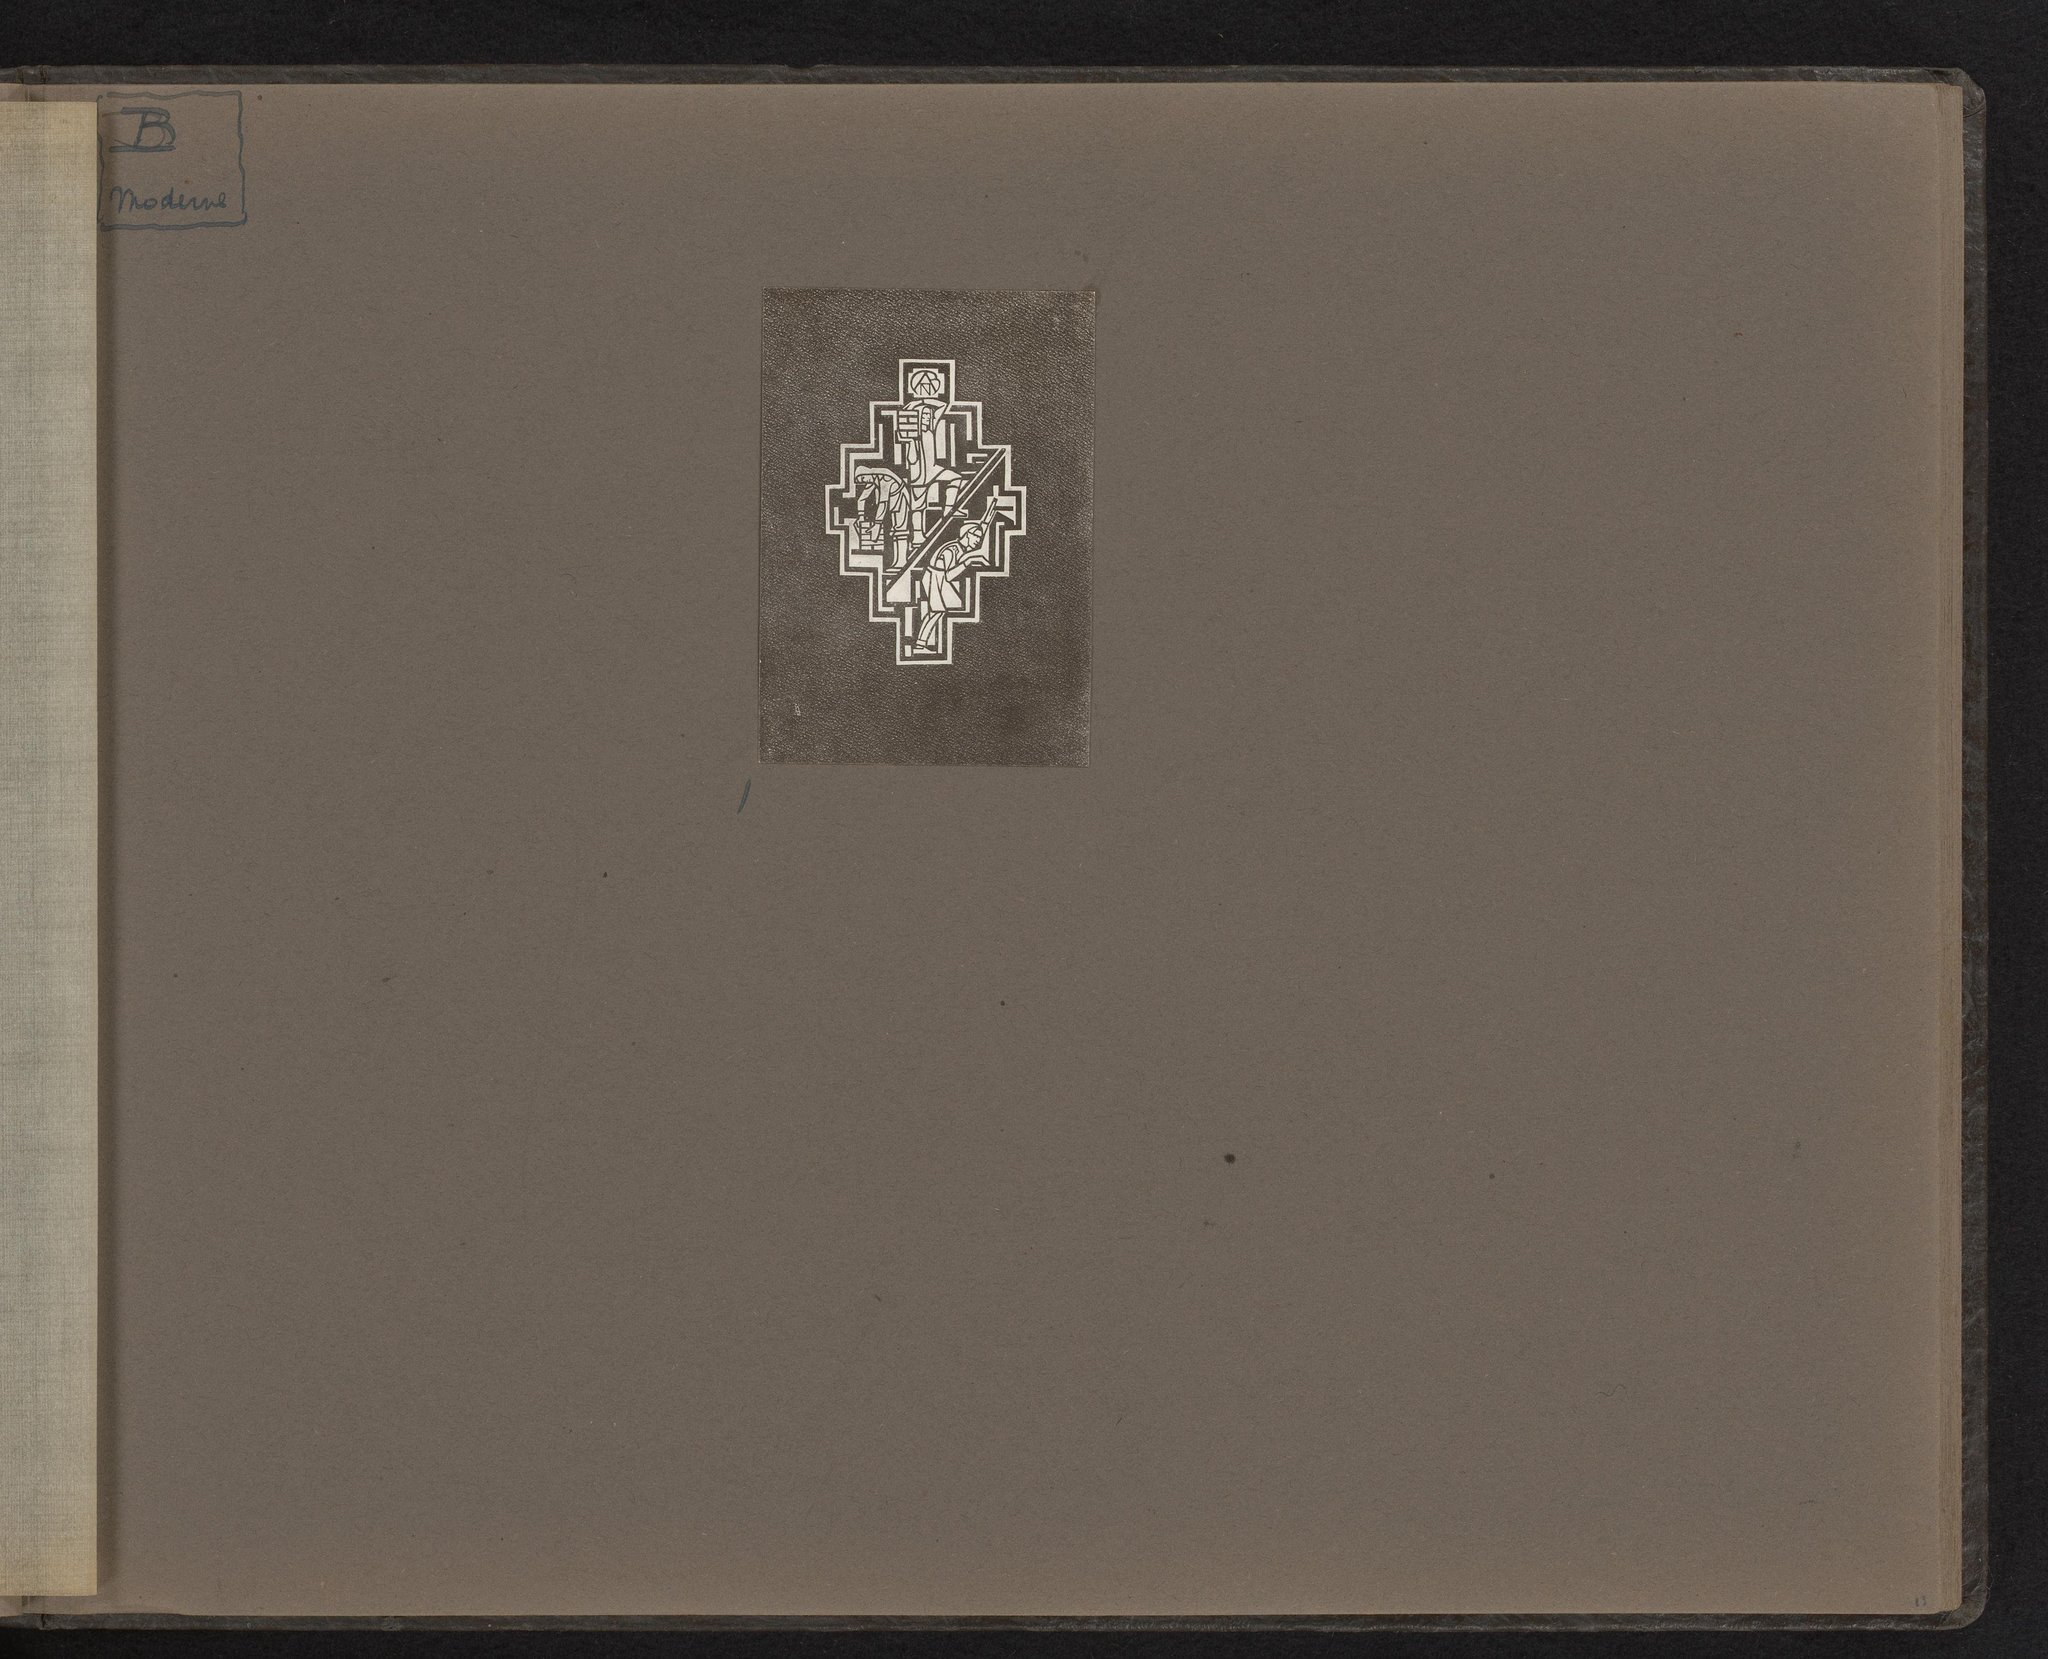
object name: album leaf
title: Boekband met embleem van de Algemene Nederlandse Diamantbewerkersbond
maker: Anonymous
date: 1920-1940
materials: paper, photographic support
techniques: gelatin silver print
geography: netherlands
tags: book-cover, binding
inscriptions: number: ‘1’, annotation: ‘B/ Moderne’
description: Deze foto's maken deel uit van een album.